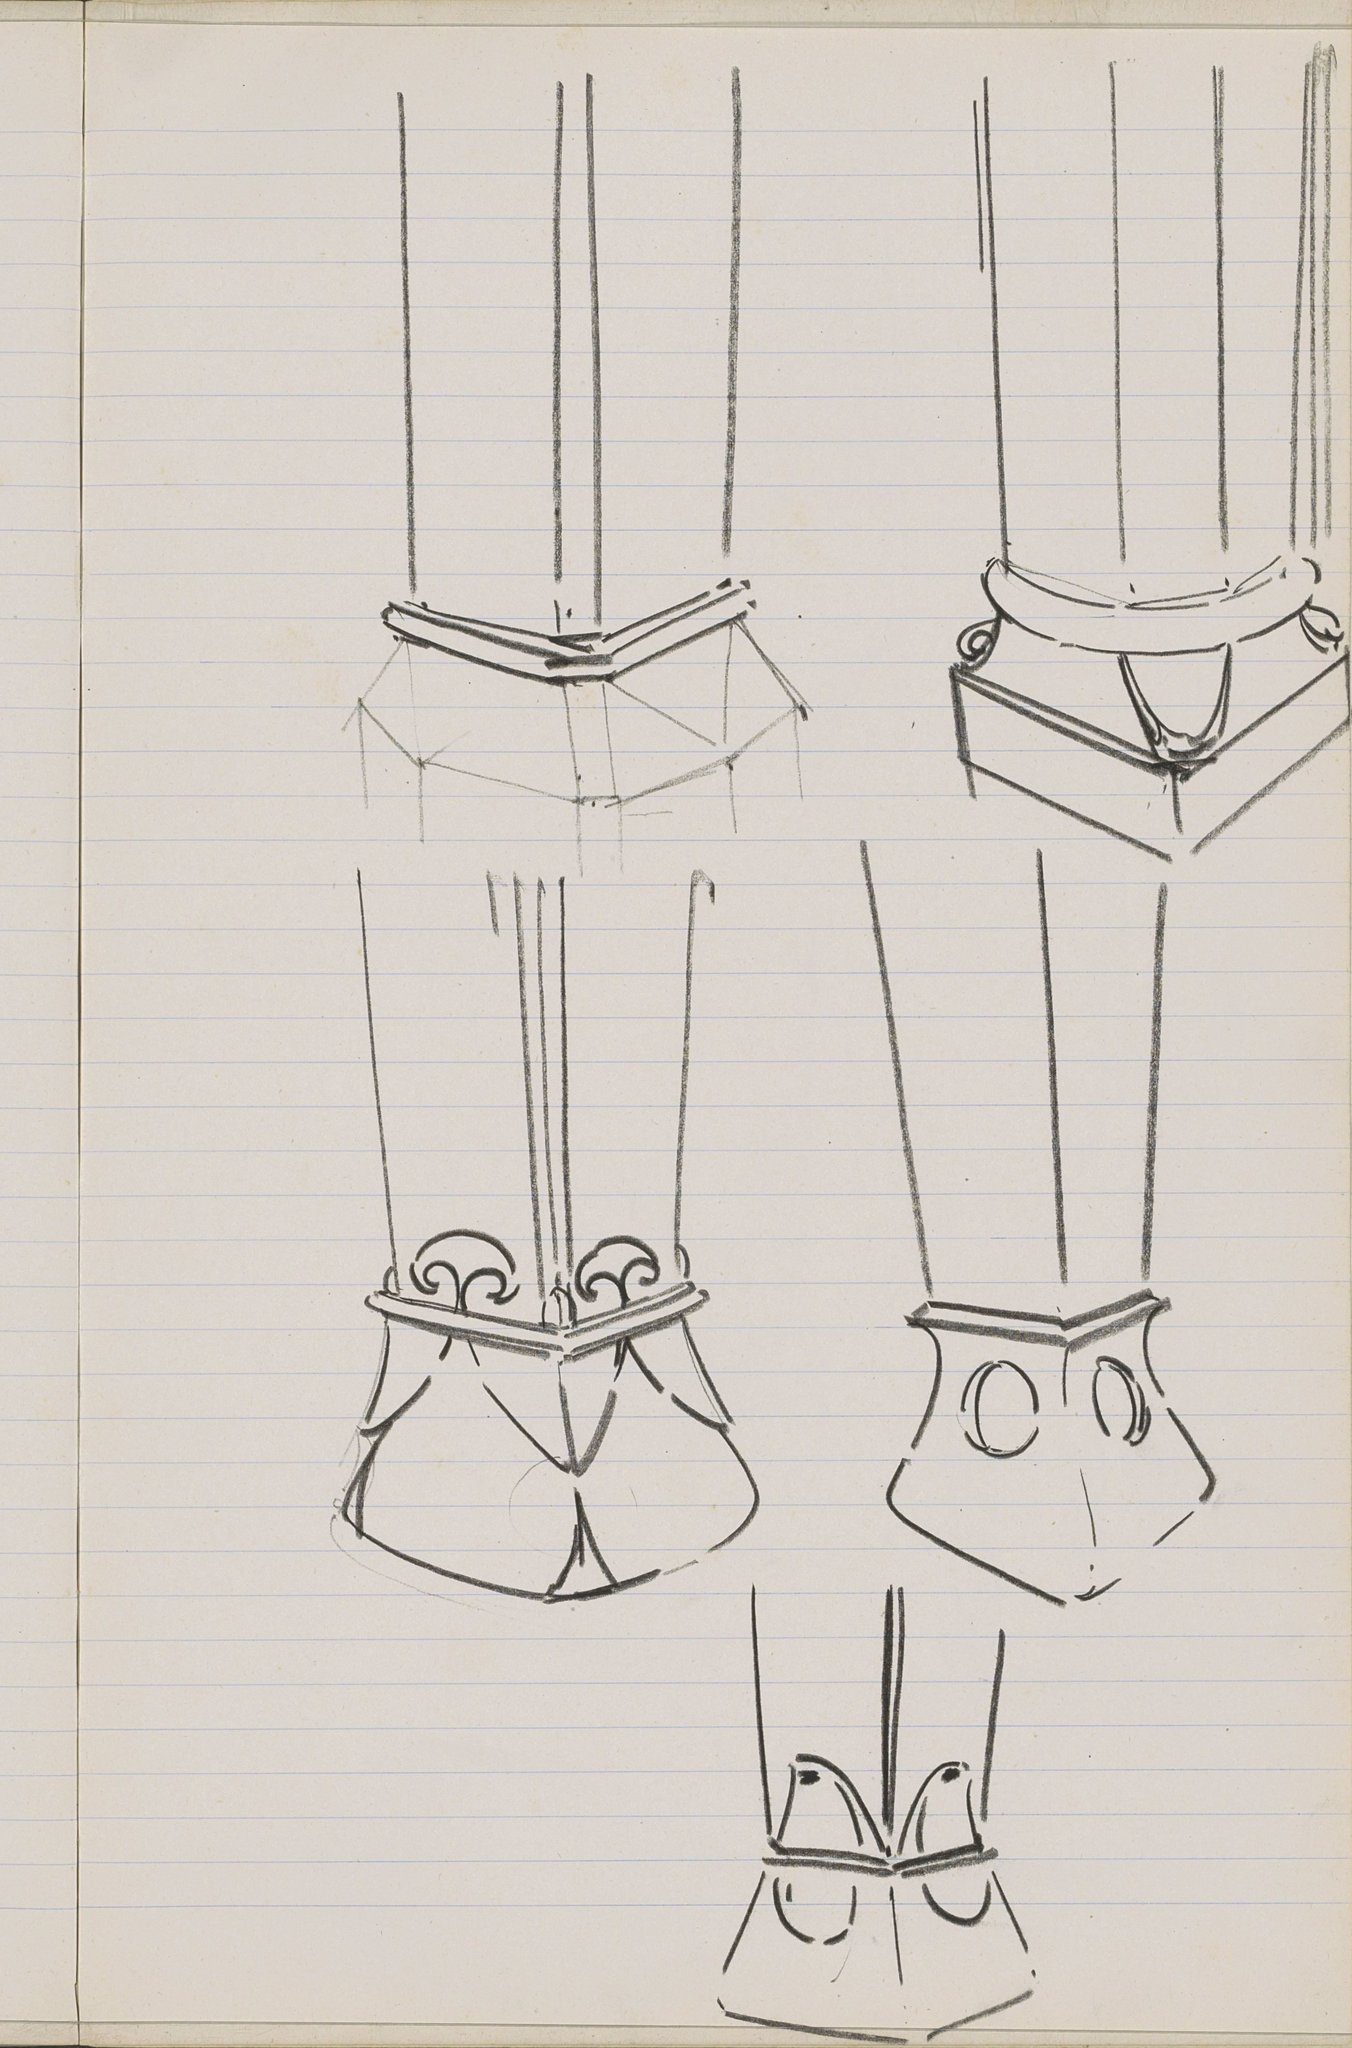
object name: sketchbook leaf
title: Tafelpoten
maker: gerrit willem dijsselhof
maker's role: designer, draughtsman, print maker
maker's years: 1866-1924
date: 1901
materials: chalk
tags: table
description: Blad 27 recto uit een schetsboek met 79 bladen.